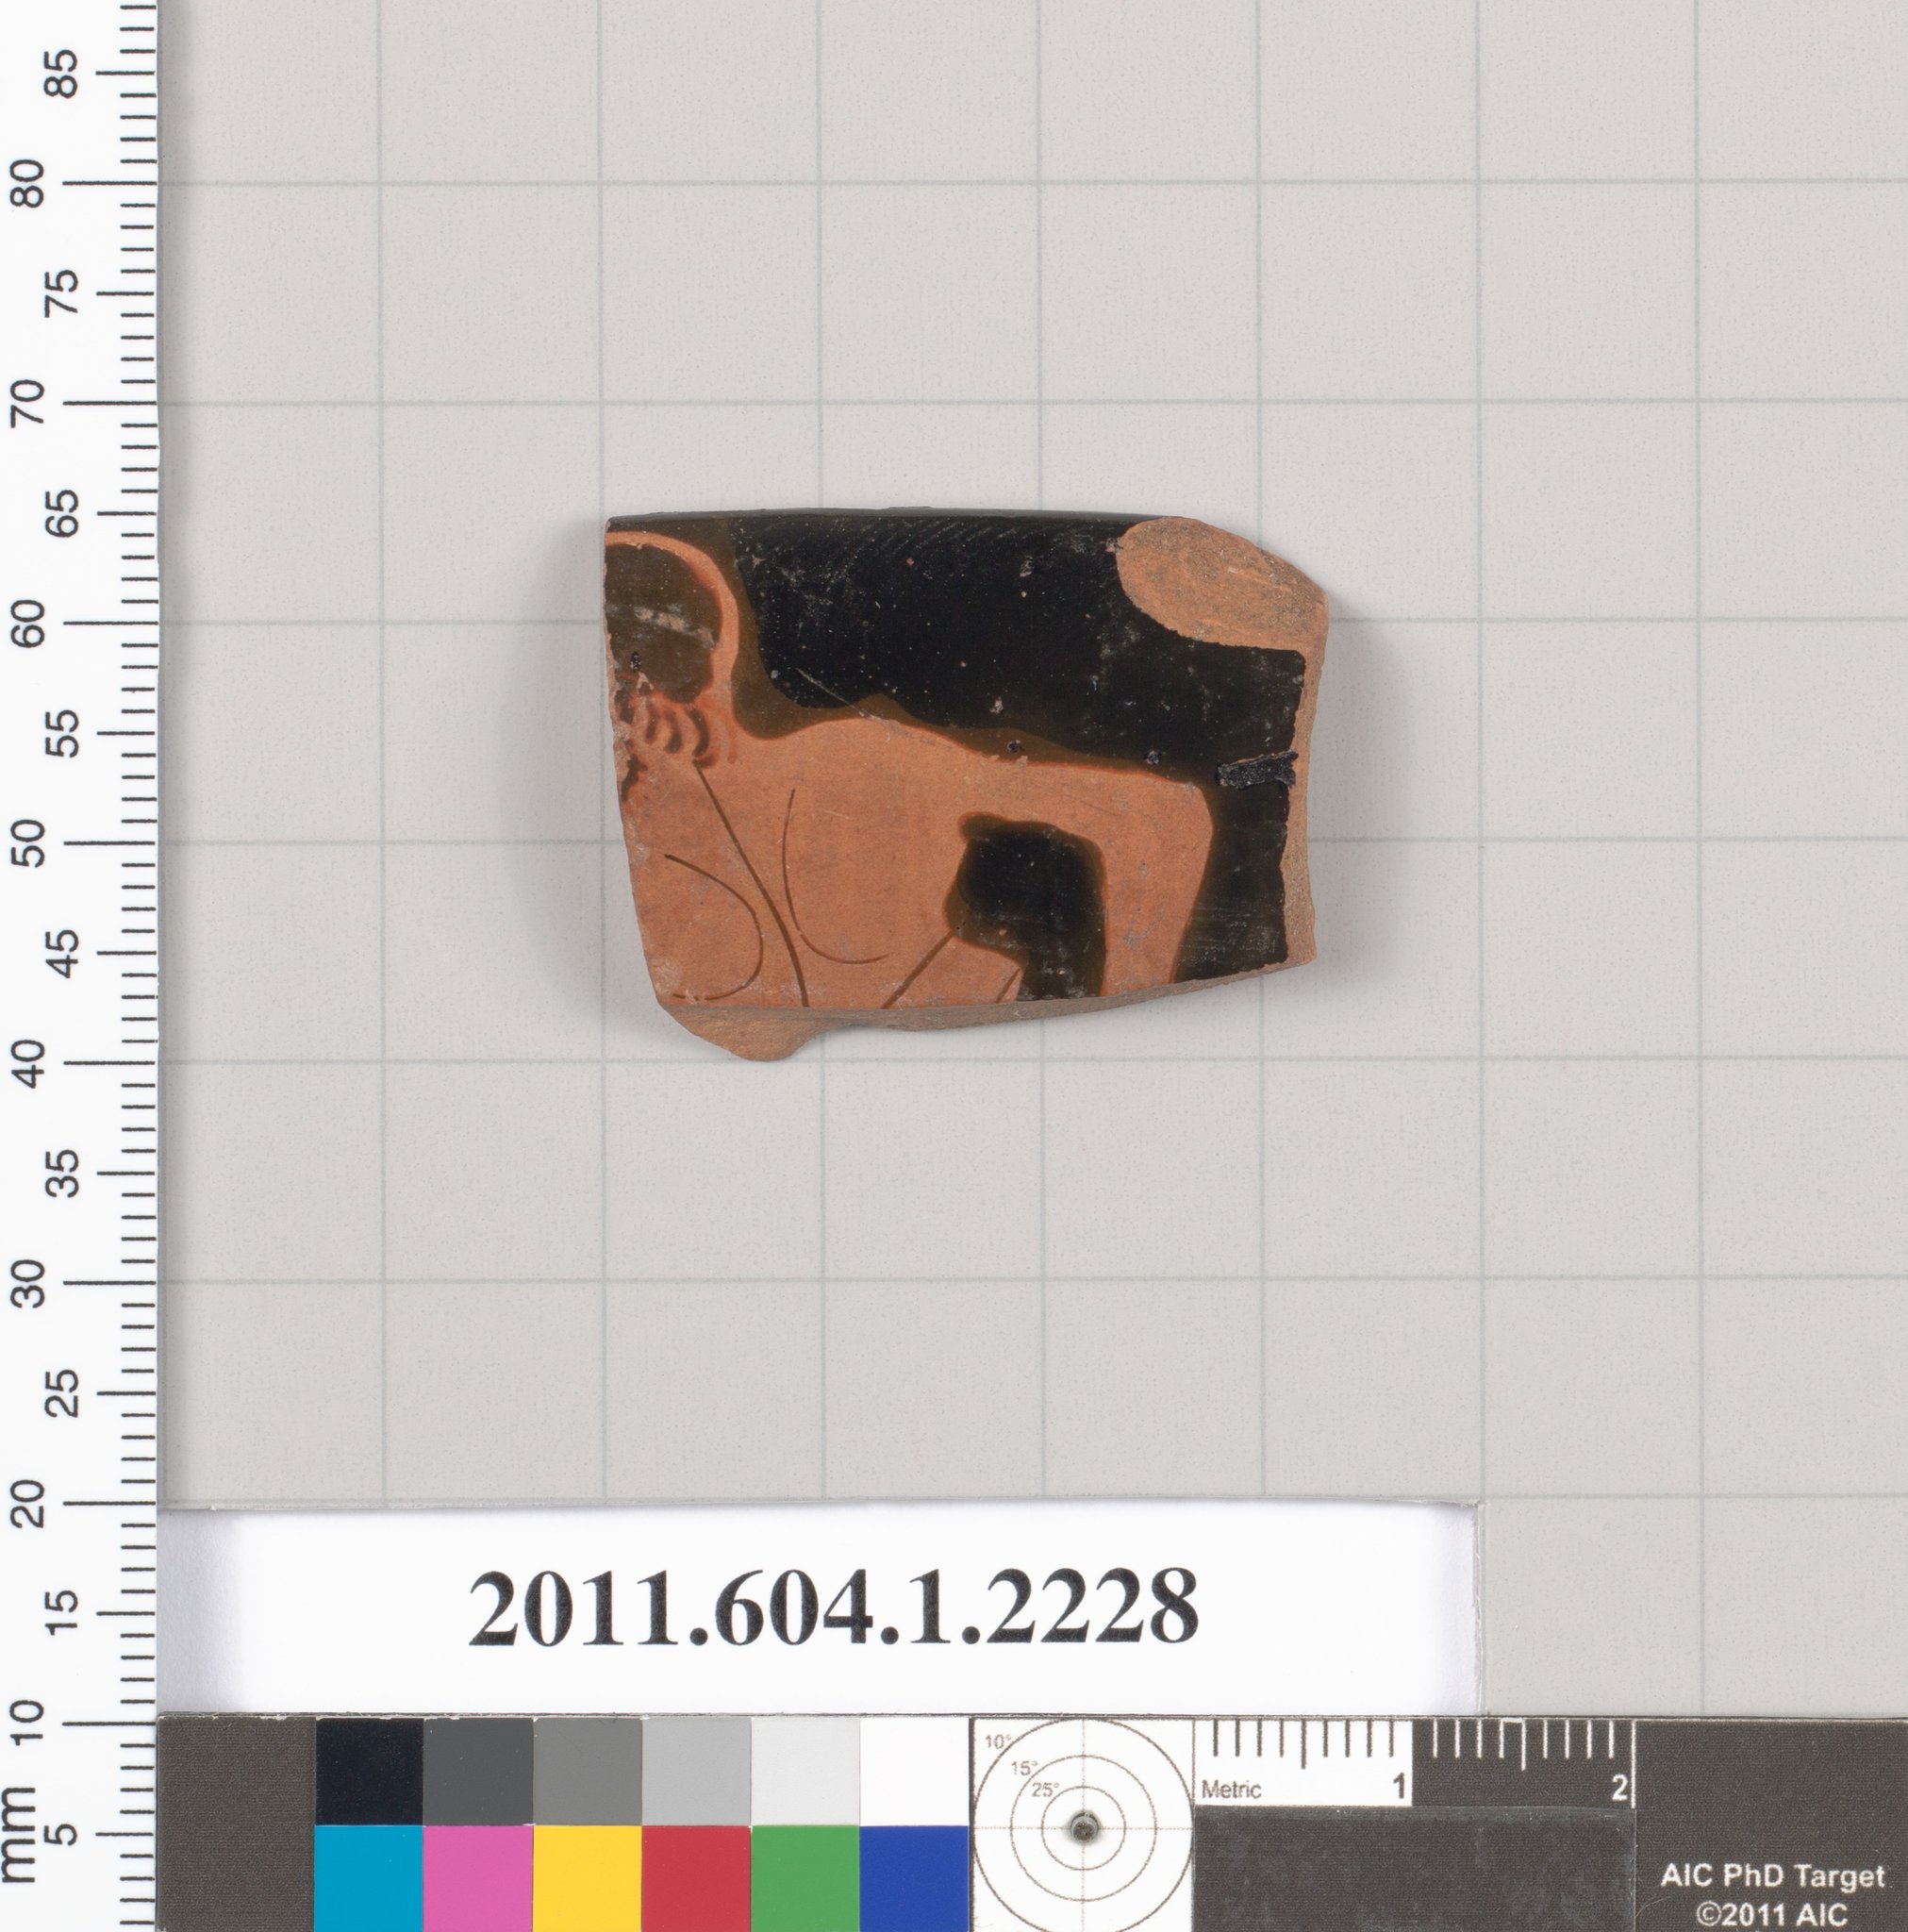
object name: kylix fragment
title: Terracotta rim fragment of a kylix (drinking cup)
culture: greek, attic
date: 467-435 BCE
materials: terracotta